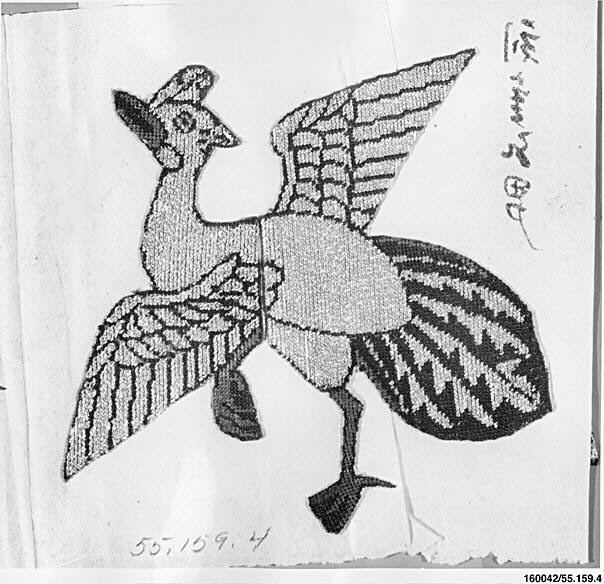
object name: appliqué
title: Applique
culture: chinese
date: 1867-1933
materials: metal thread, silk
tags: pheasants